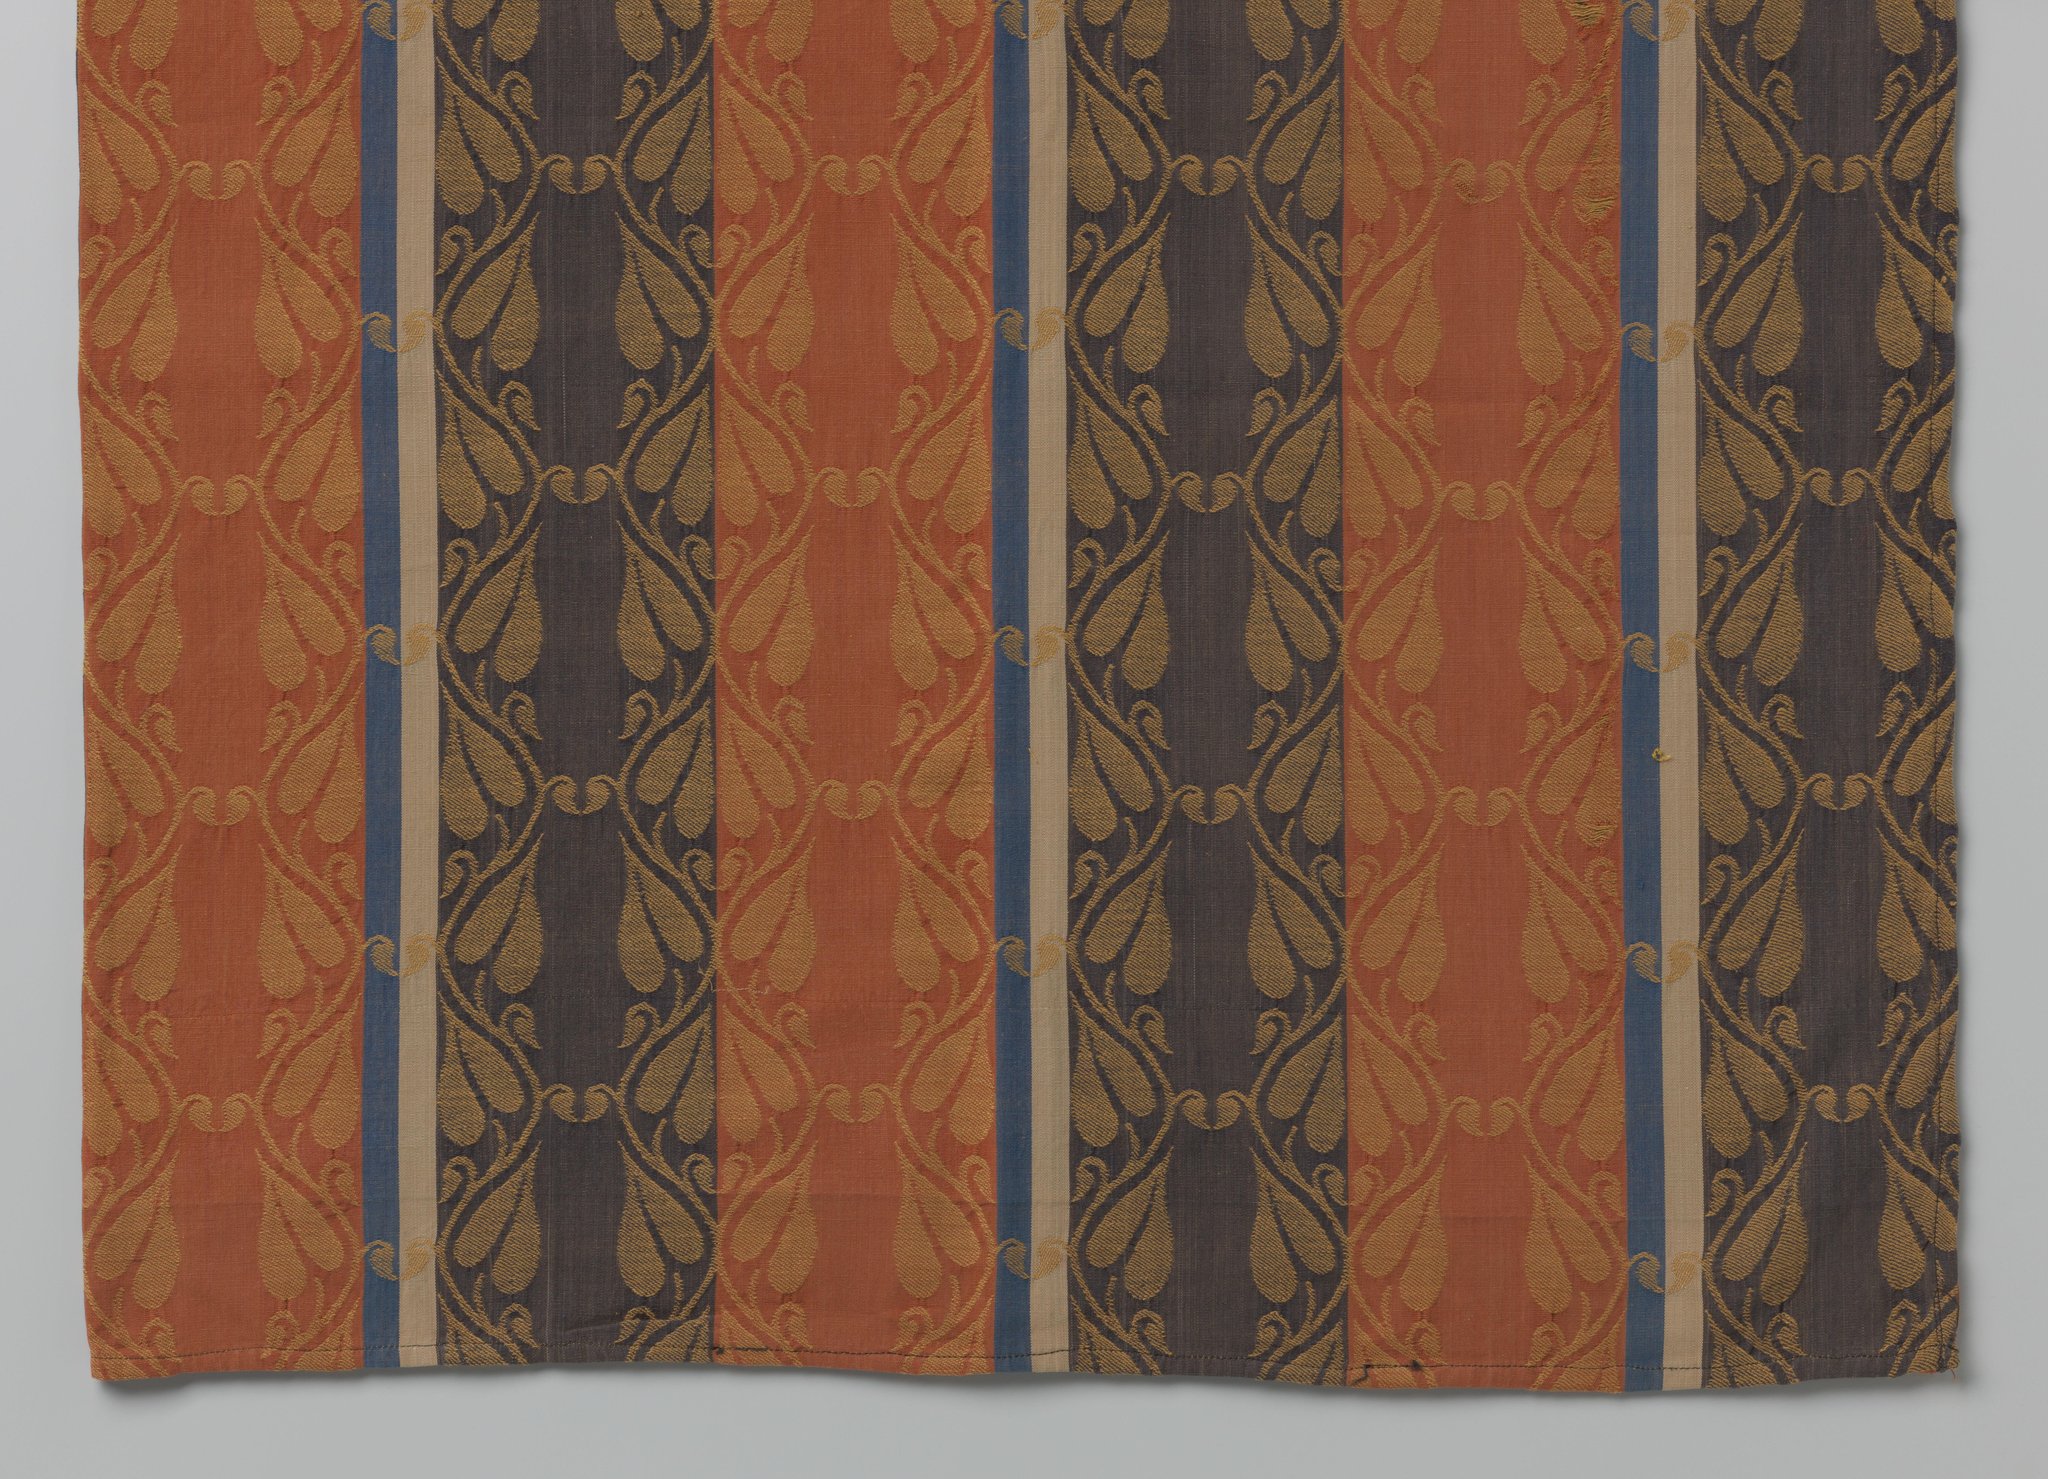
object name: gordijnstof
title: Gordijnstof met rode en zwarte verticale banen met geel ornament van geslingerde takken met bladeren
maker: theo nieuwenhuis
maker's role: designer, draughtsman, print maker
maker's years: 1866-1951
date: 1900-1930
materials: cotton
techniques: jacquard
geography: netherlands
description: Katoenen gordijnstof met rode en zwarte verticale banen met een geel ornament van geslingerde takken met bladeren, geflankeerd door blauwe en witte lengtestrepen.